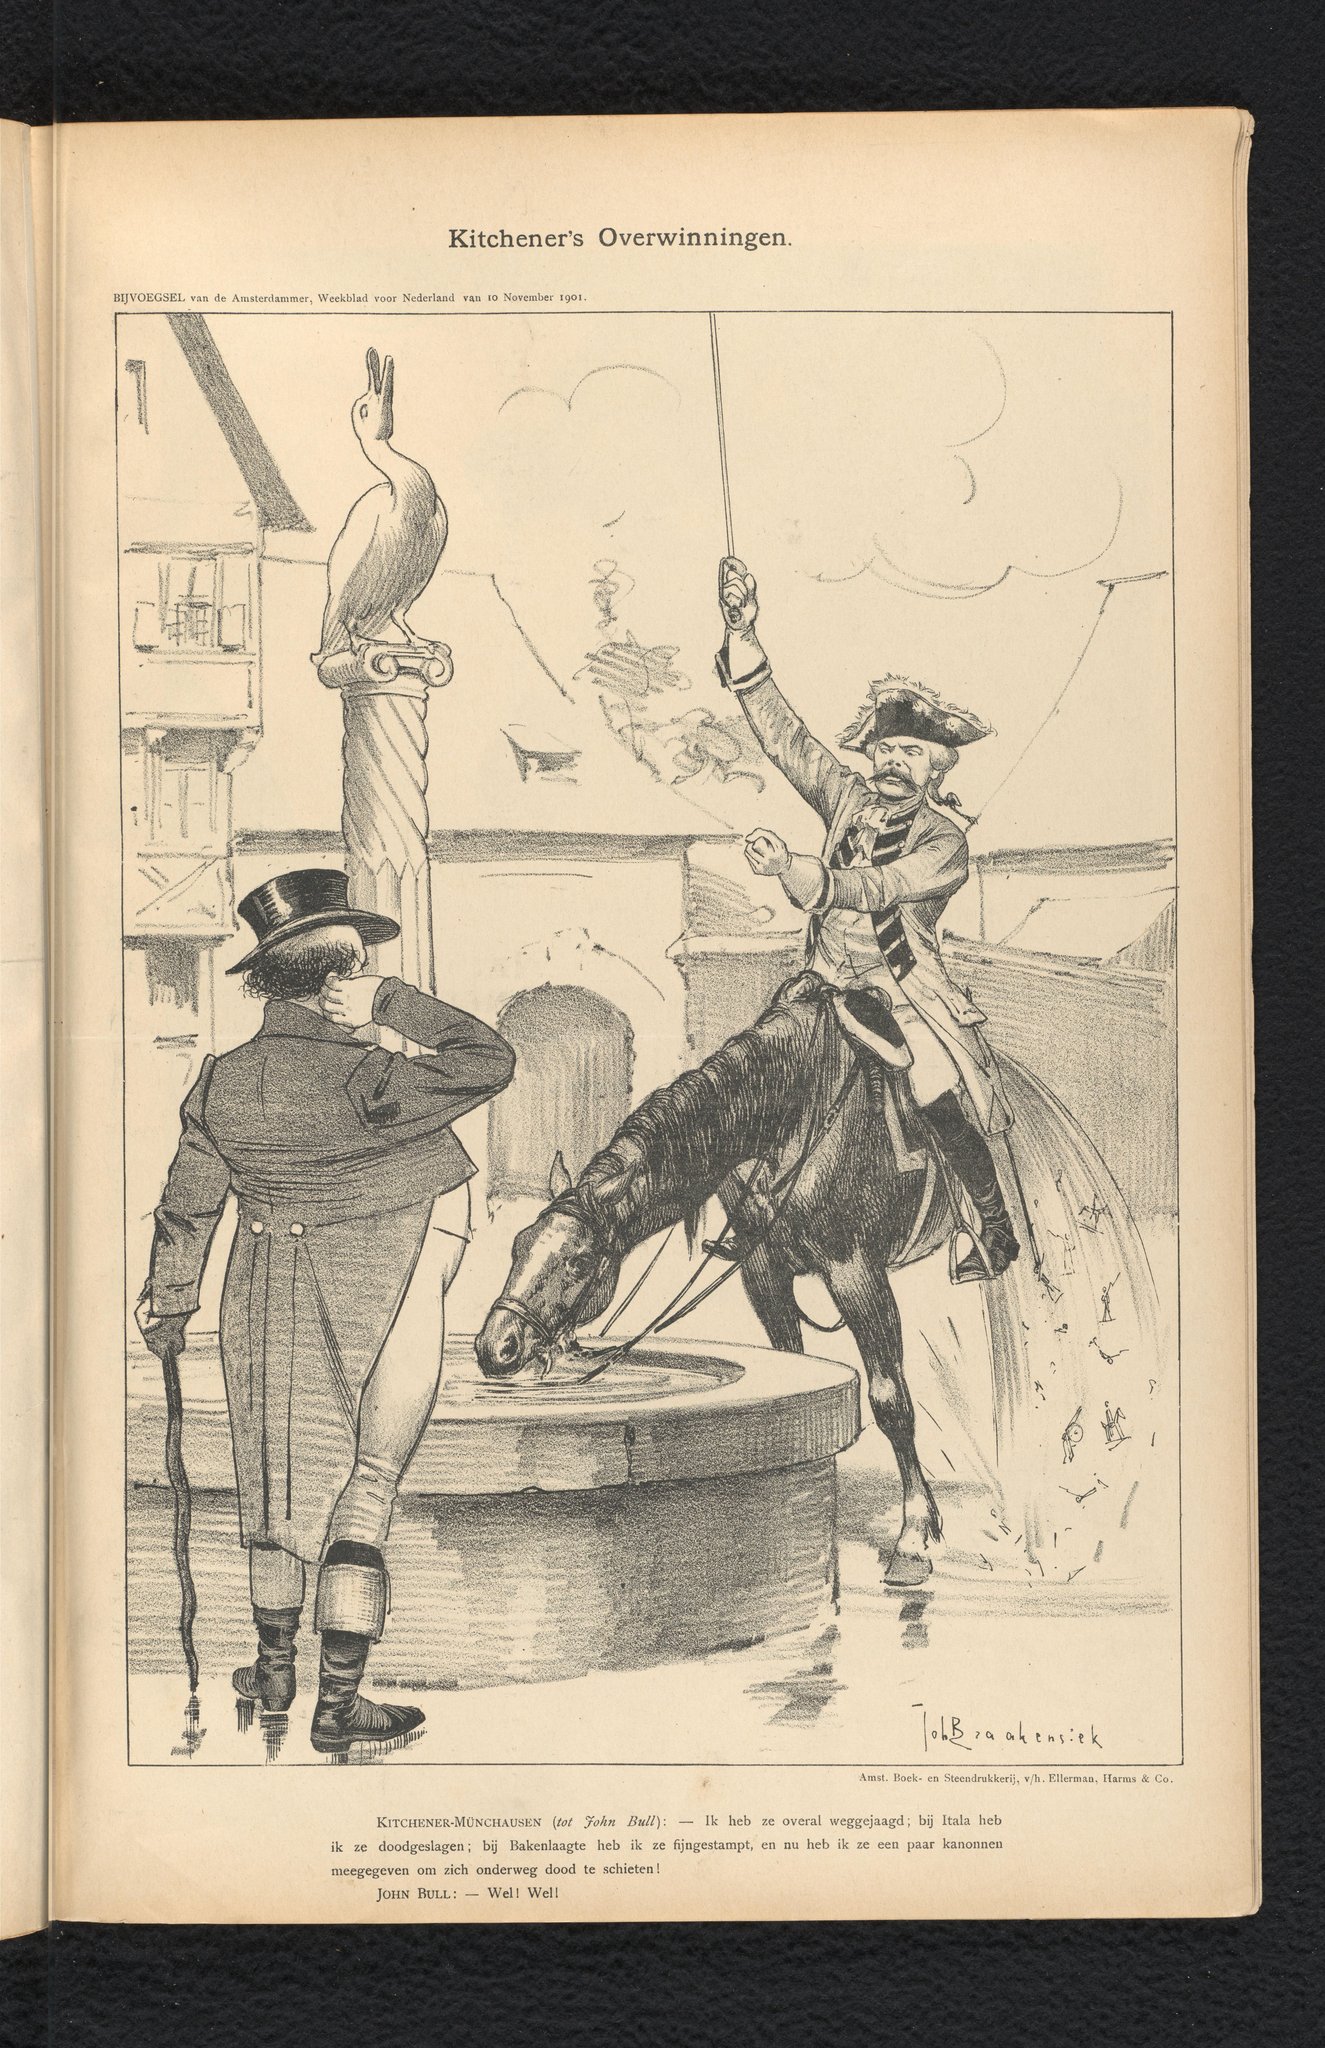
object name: cartoon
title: Kitchener's Overwinningen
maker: johan braakensiek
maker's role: draughtsman, print maker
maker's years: 1858-1940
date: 1901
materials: paper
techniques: lithograph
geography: netherlands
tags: horatio herbert kitchener, personifications of countries, nations, states, districts, etc., baron münchausen, political caricatures and satires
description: Lord Kitchener als de Baron van Münchhausen tegenover John Bull (Engeland) opscheppend over zijn overwinningen in de Boerenoorlog.